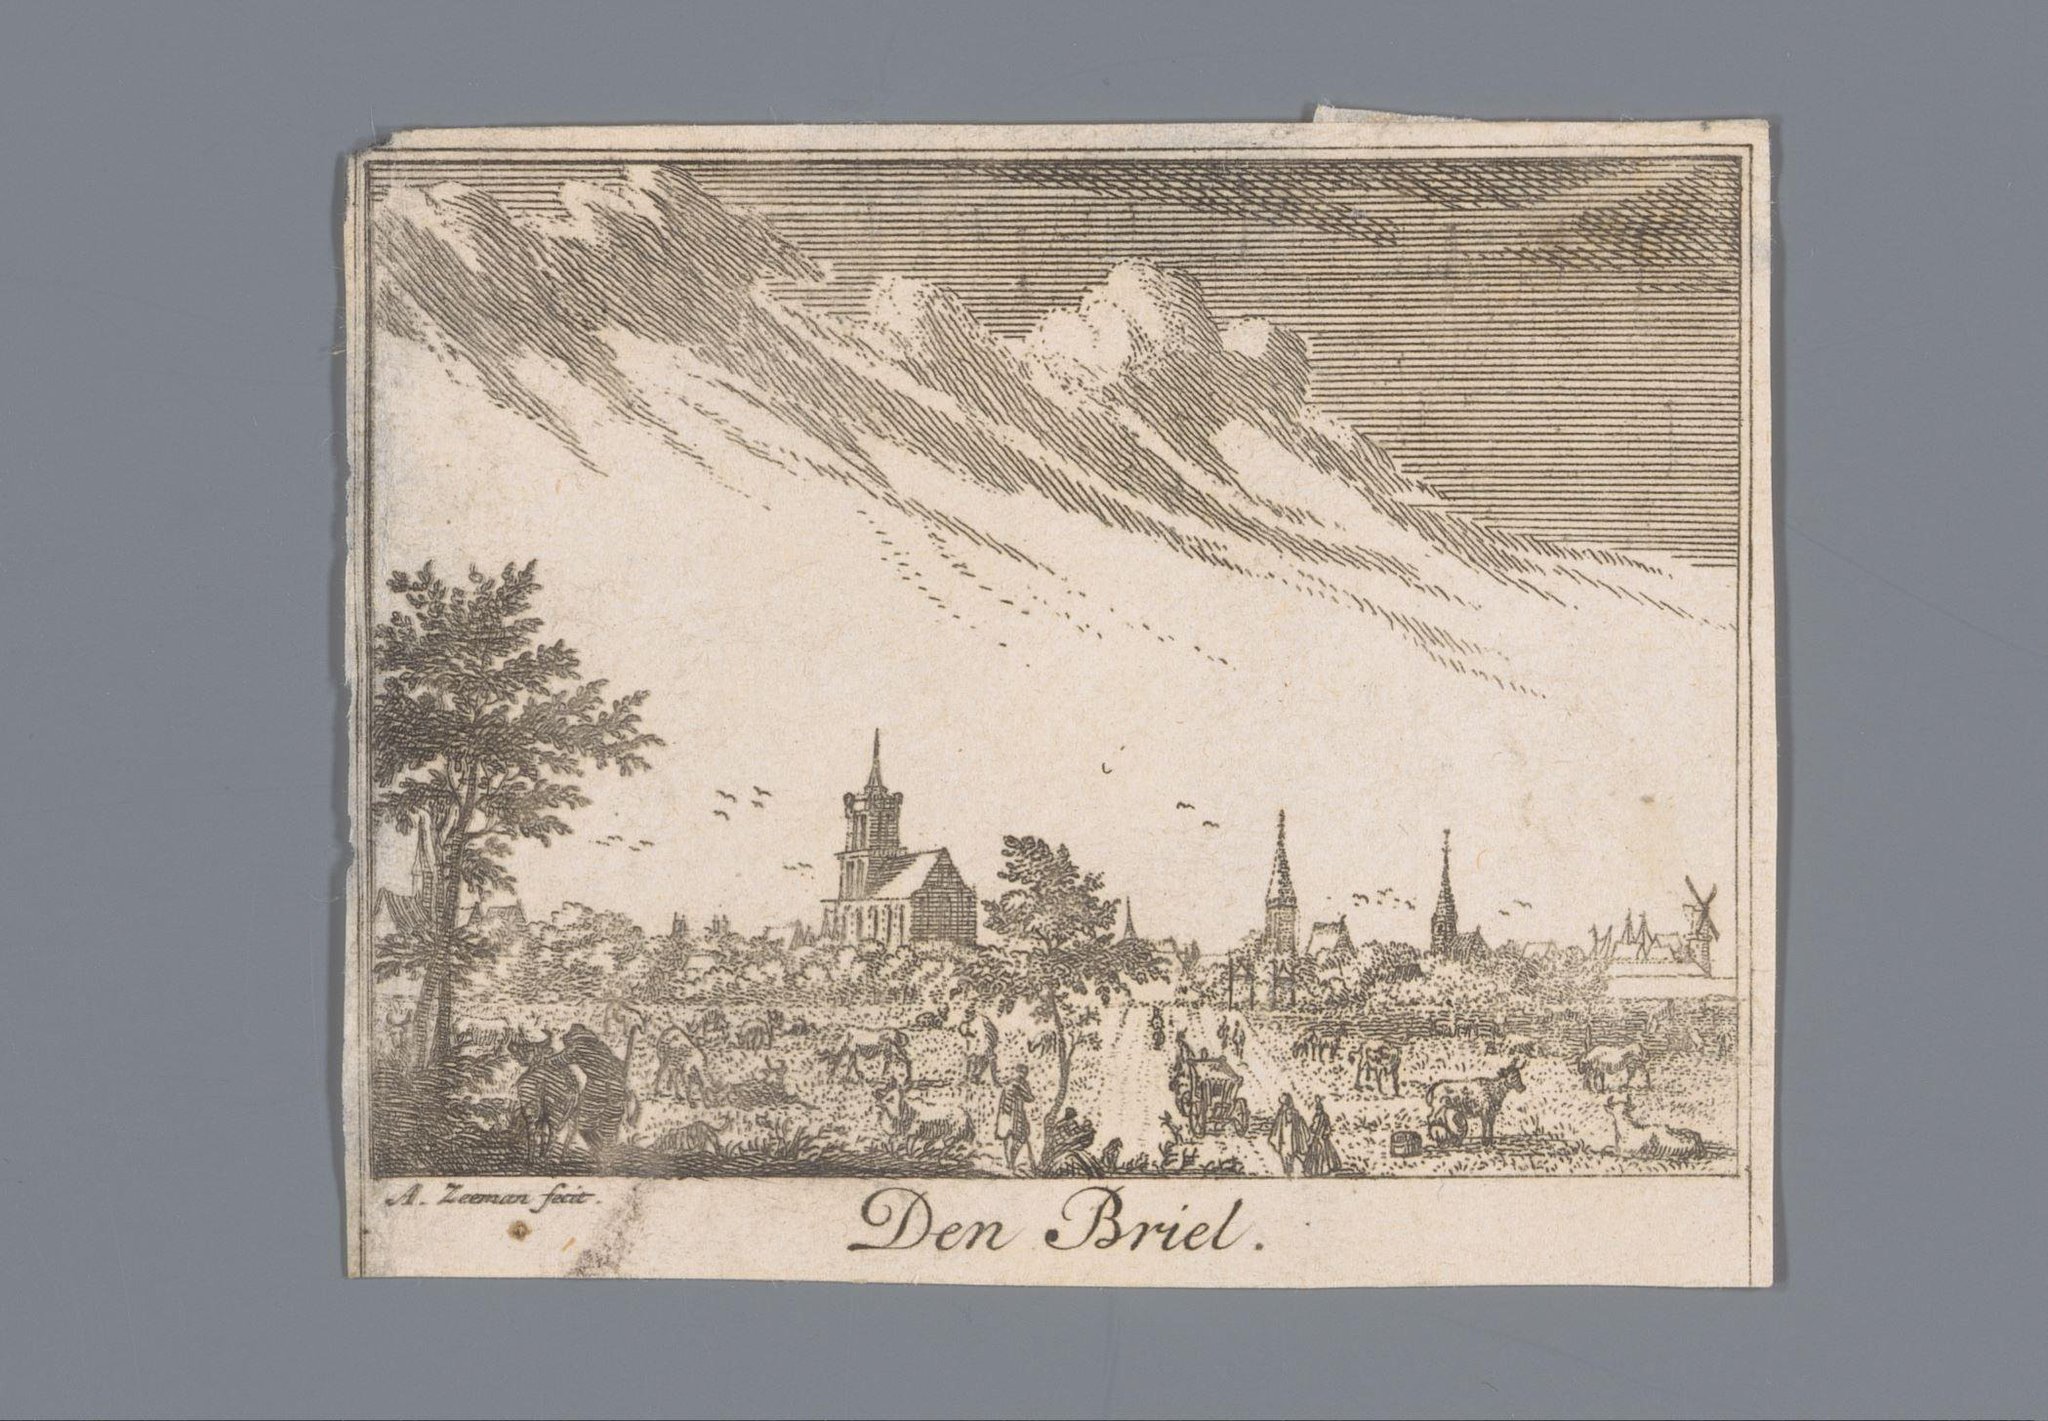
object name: print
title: Gezicht op Brielle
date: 1716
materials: paper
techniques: etching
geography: amsterdam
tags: prospect of city, town panorama, silhouette of city (+ city(-scape) with figures, staffage), brielle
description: Prent uit: Bruin, Claas. Kleefsche en Zuid-Hollandsche Arkadia of Kabinet (...). Amsterdam: Johannes Oosterwyk en Hendrik van de Gaete, 1716.